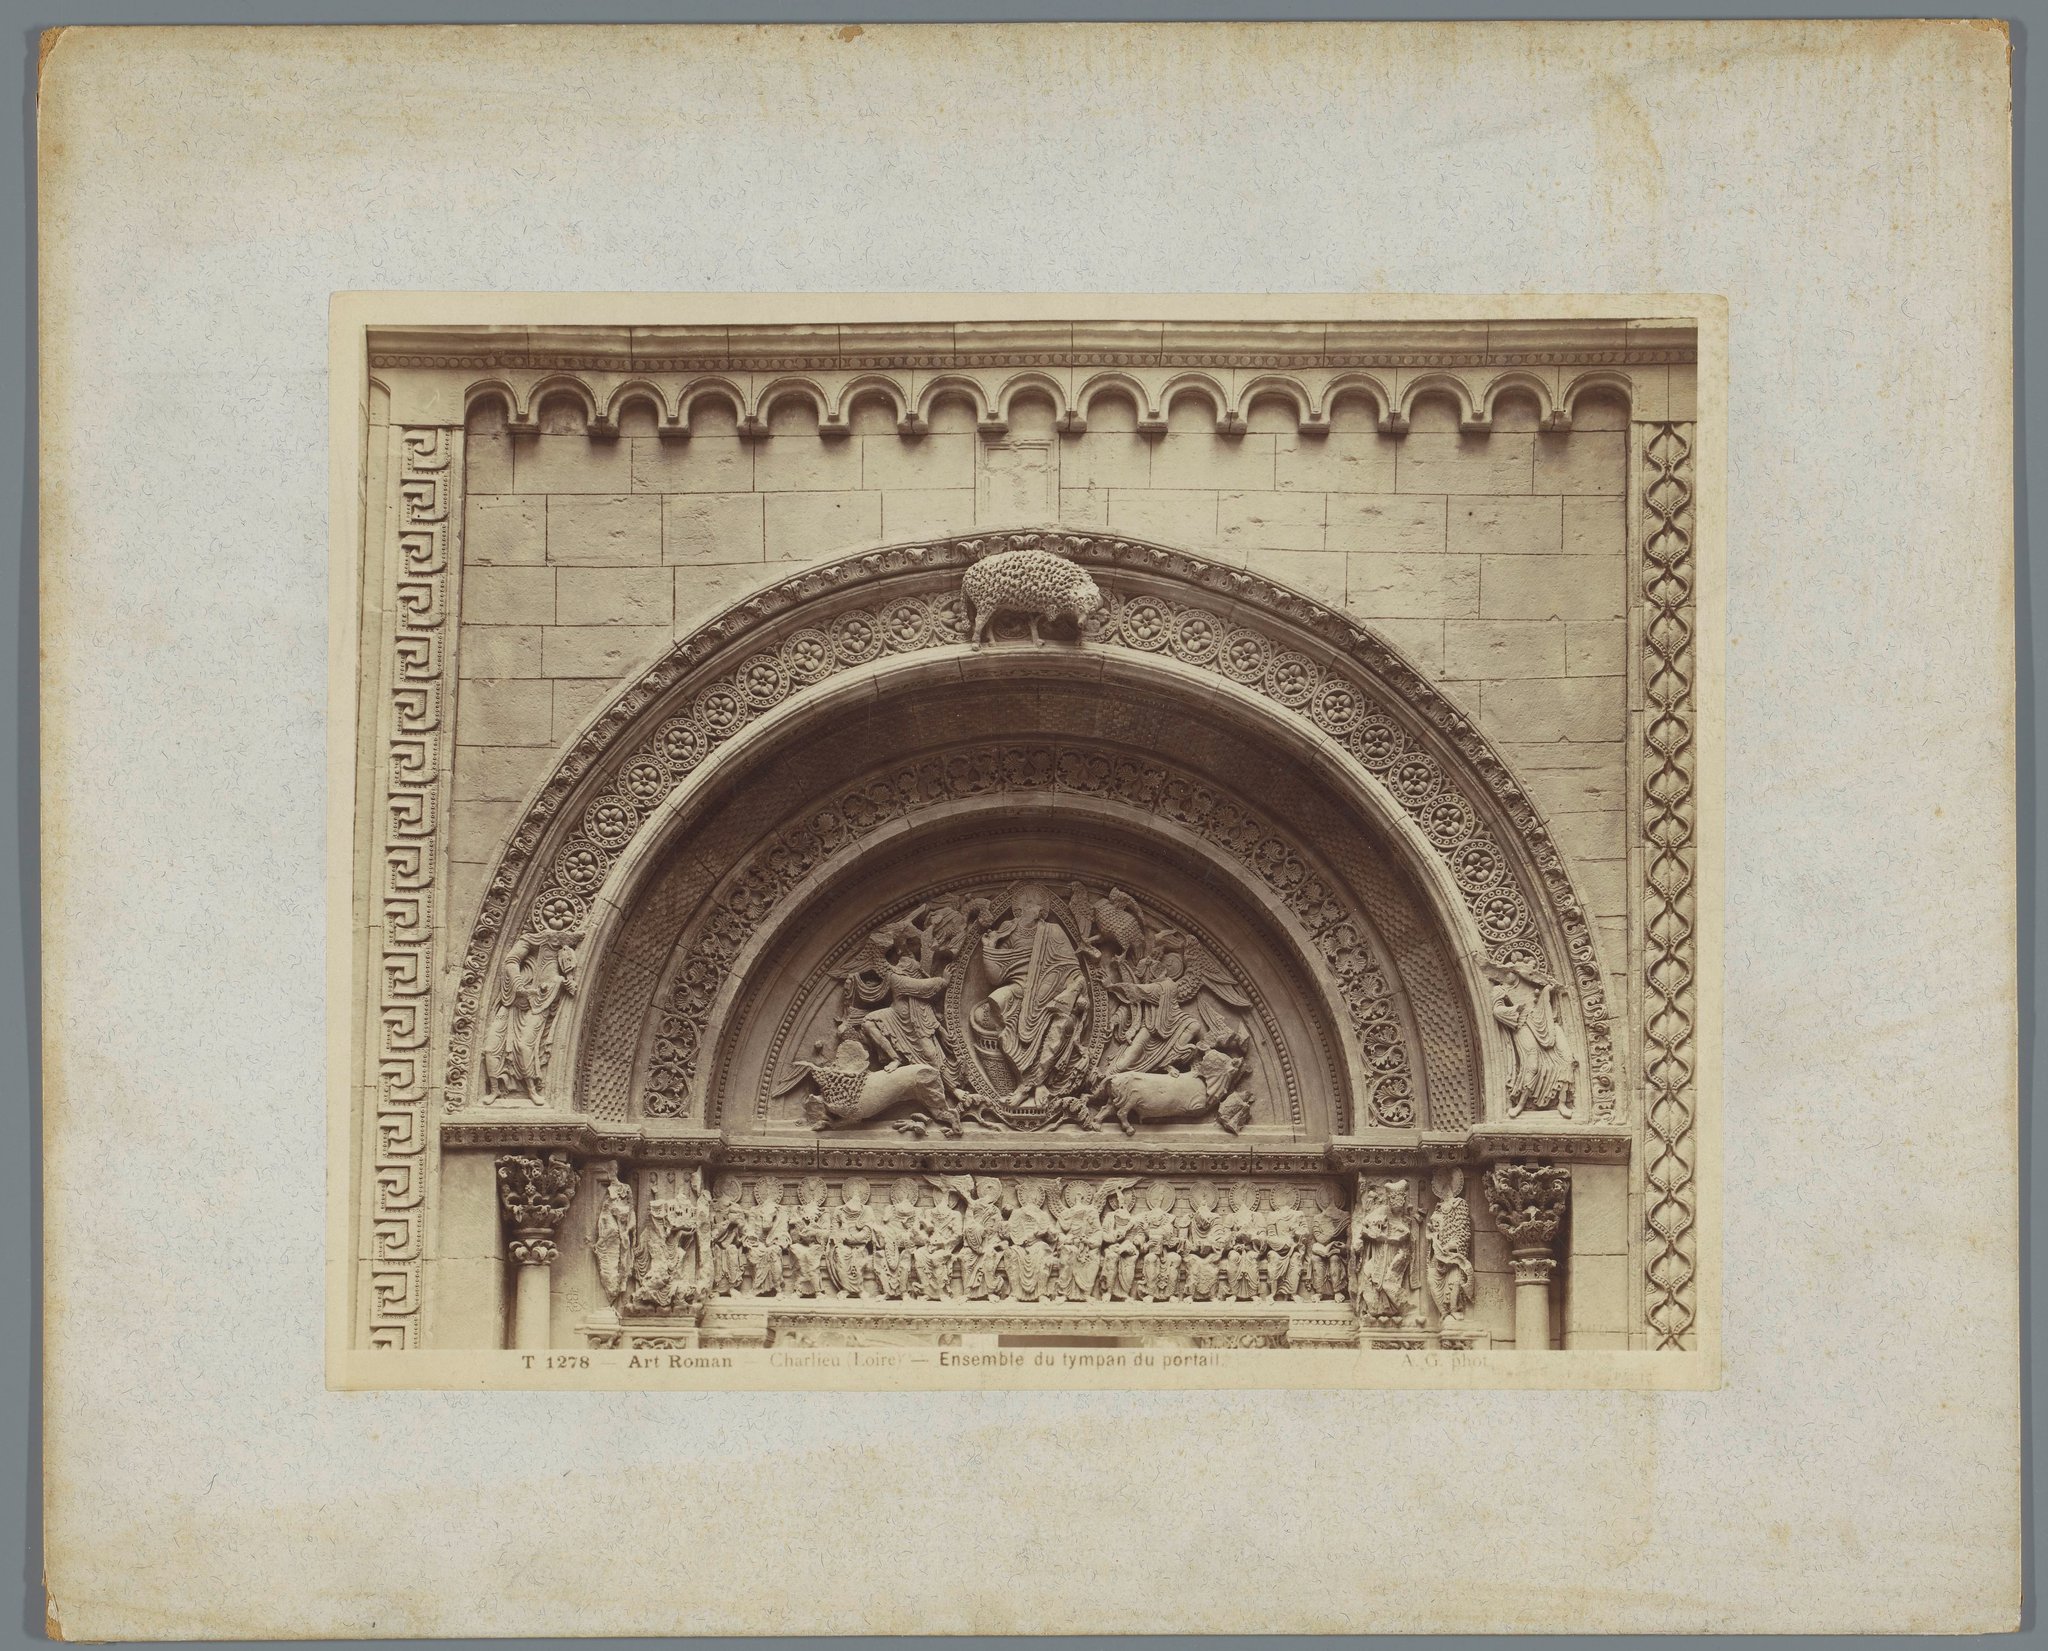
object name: photograph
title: Art Roman - Charlieu (Loire) - Ensemble du tympan du portail.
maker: adolphe giraudon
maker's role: publisher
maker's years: 1849-1929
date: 1875-1900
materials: cardboard, photographic support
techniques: albumen print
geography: charlieu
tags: parts of church exterior and annexes: portal, sculpture (+ relief ~ sculpture)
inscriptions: collector's mark: ‘RIJKS-NORMAALSCHOOL voor TEEKENONDERWIJZERS AMSTERDAM’, name: ‘A. GIRAUDON ÉDITEUR 15, R. BONAPARTE, PARIS’, number: ‘T 1278’